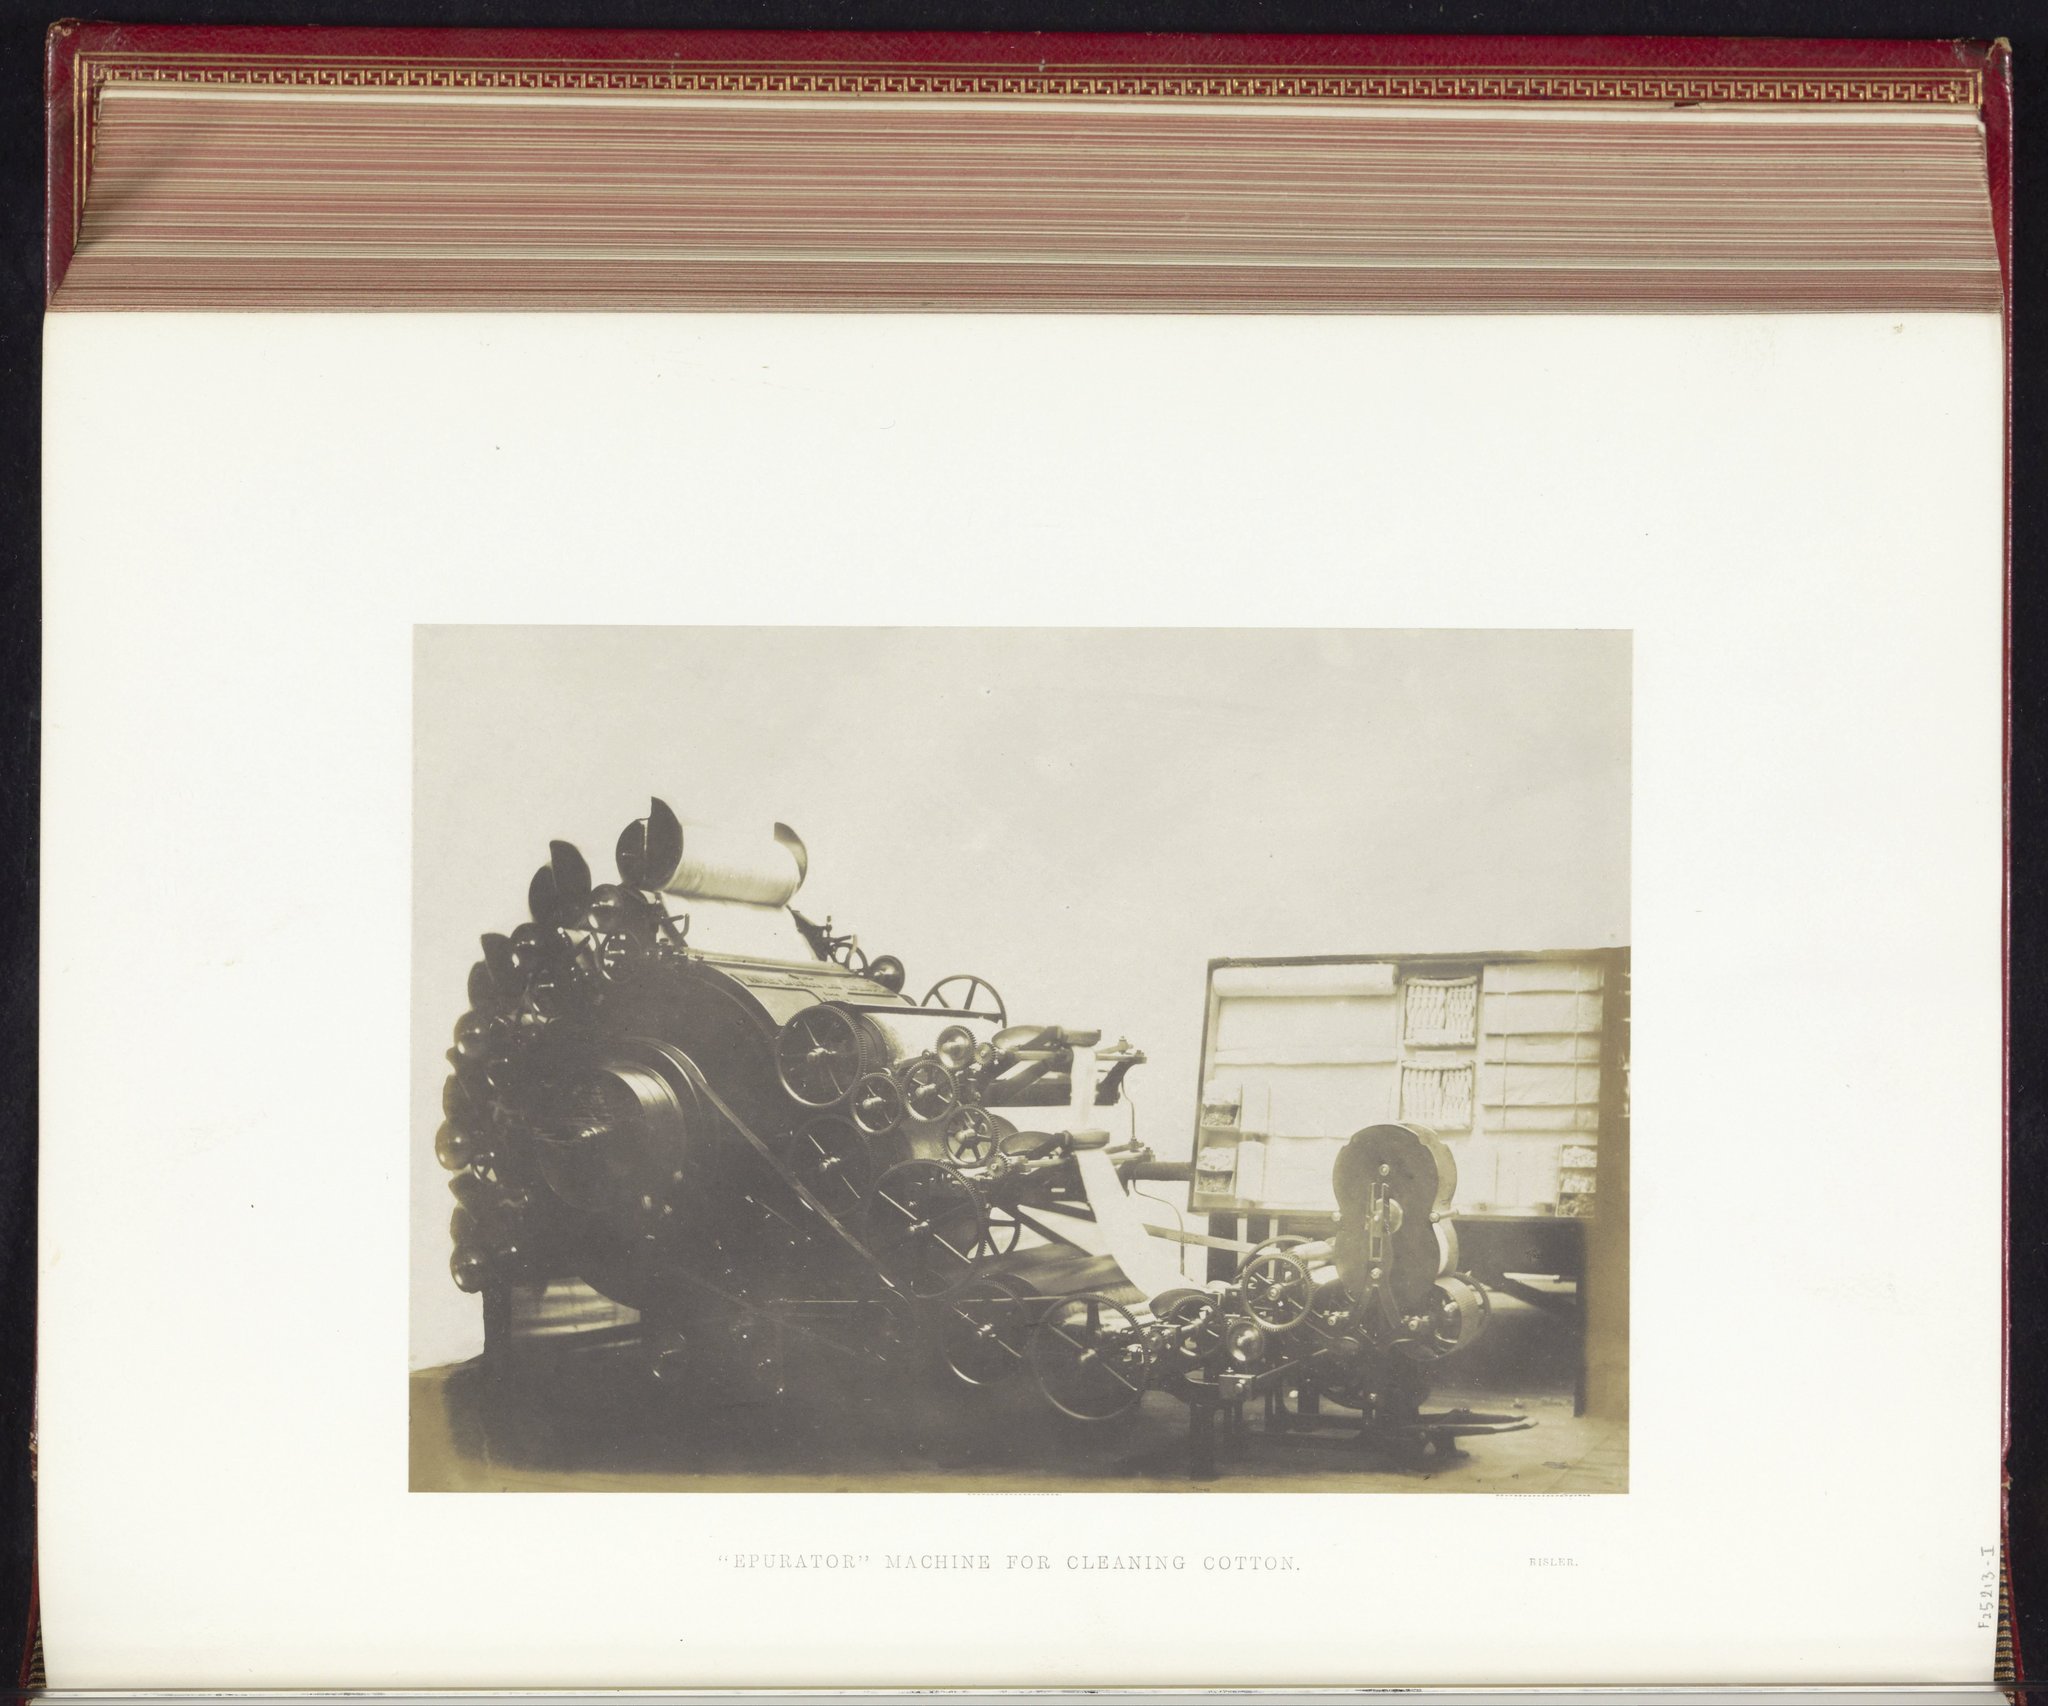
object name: page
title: "Epurator" Machine for Cleaning Cotton. Risler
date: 1851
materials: photographic support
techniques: salted paper print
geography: london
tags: cotton (material ~ textile industry), machines; parts of machines; tools and appliances, london